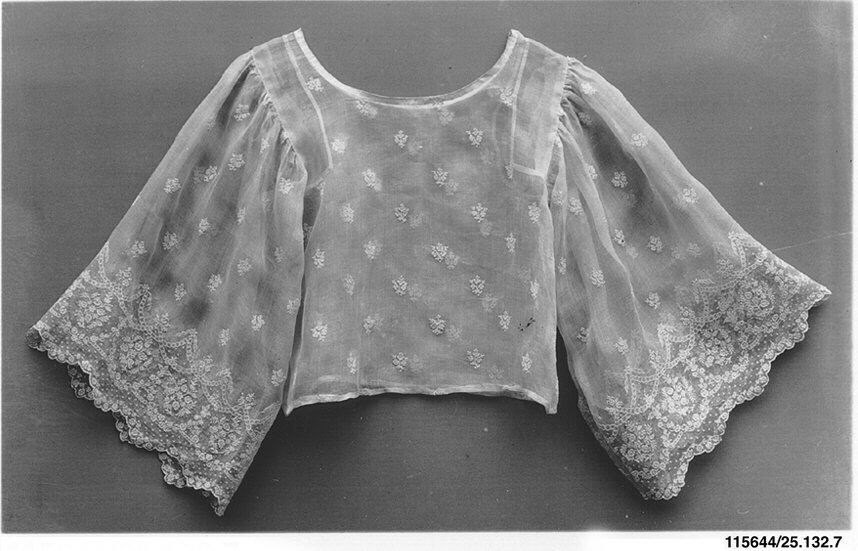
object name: blouse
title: Blouse (Camisa)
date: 1801-1850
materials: fiber, linen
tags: flowers